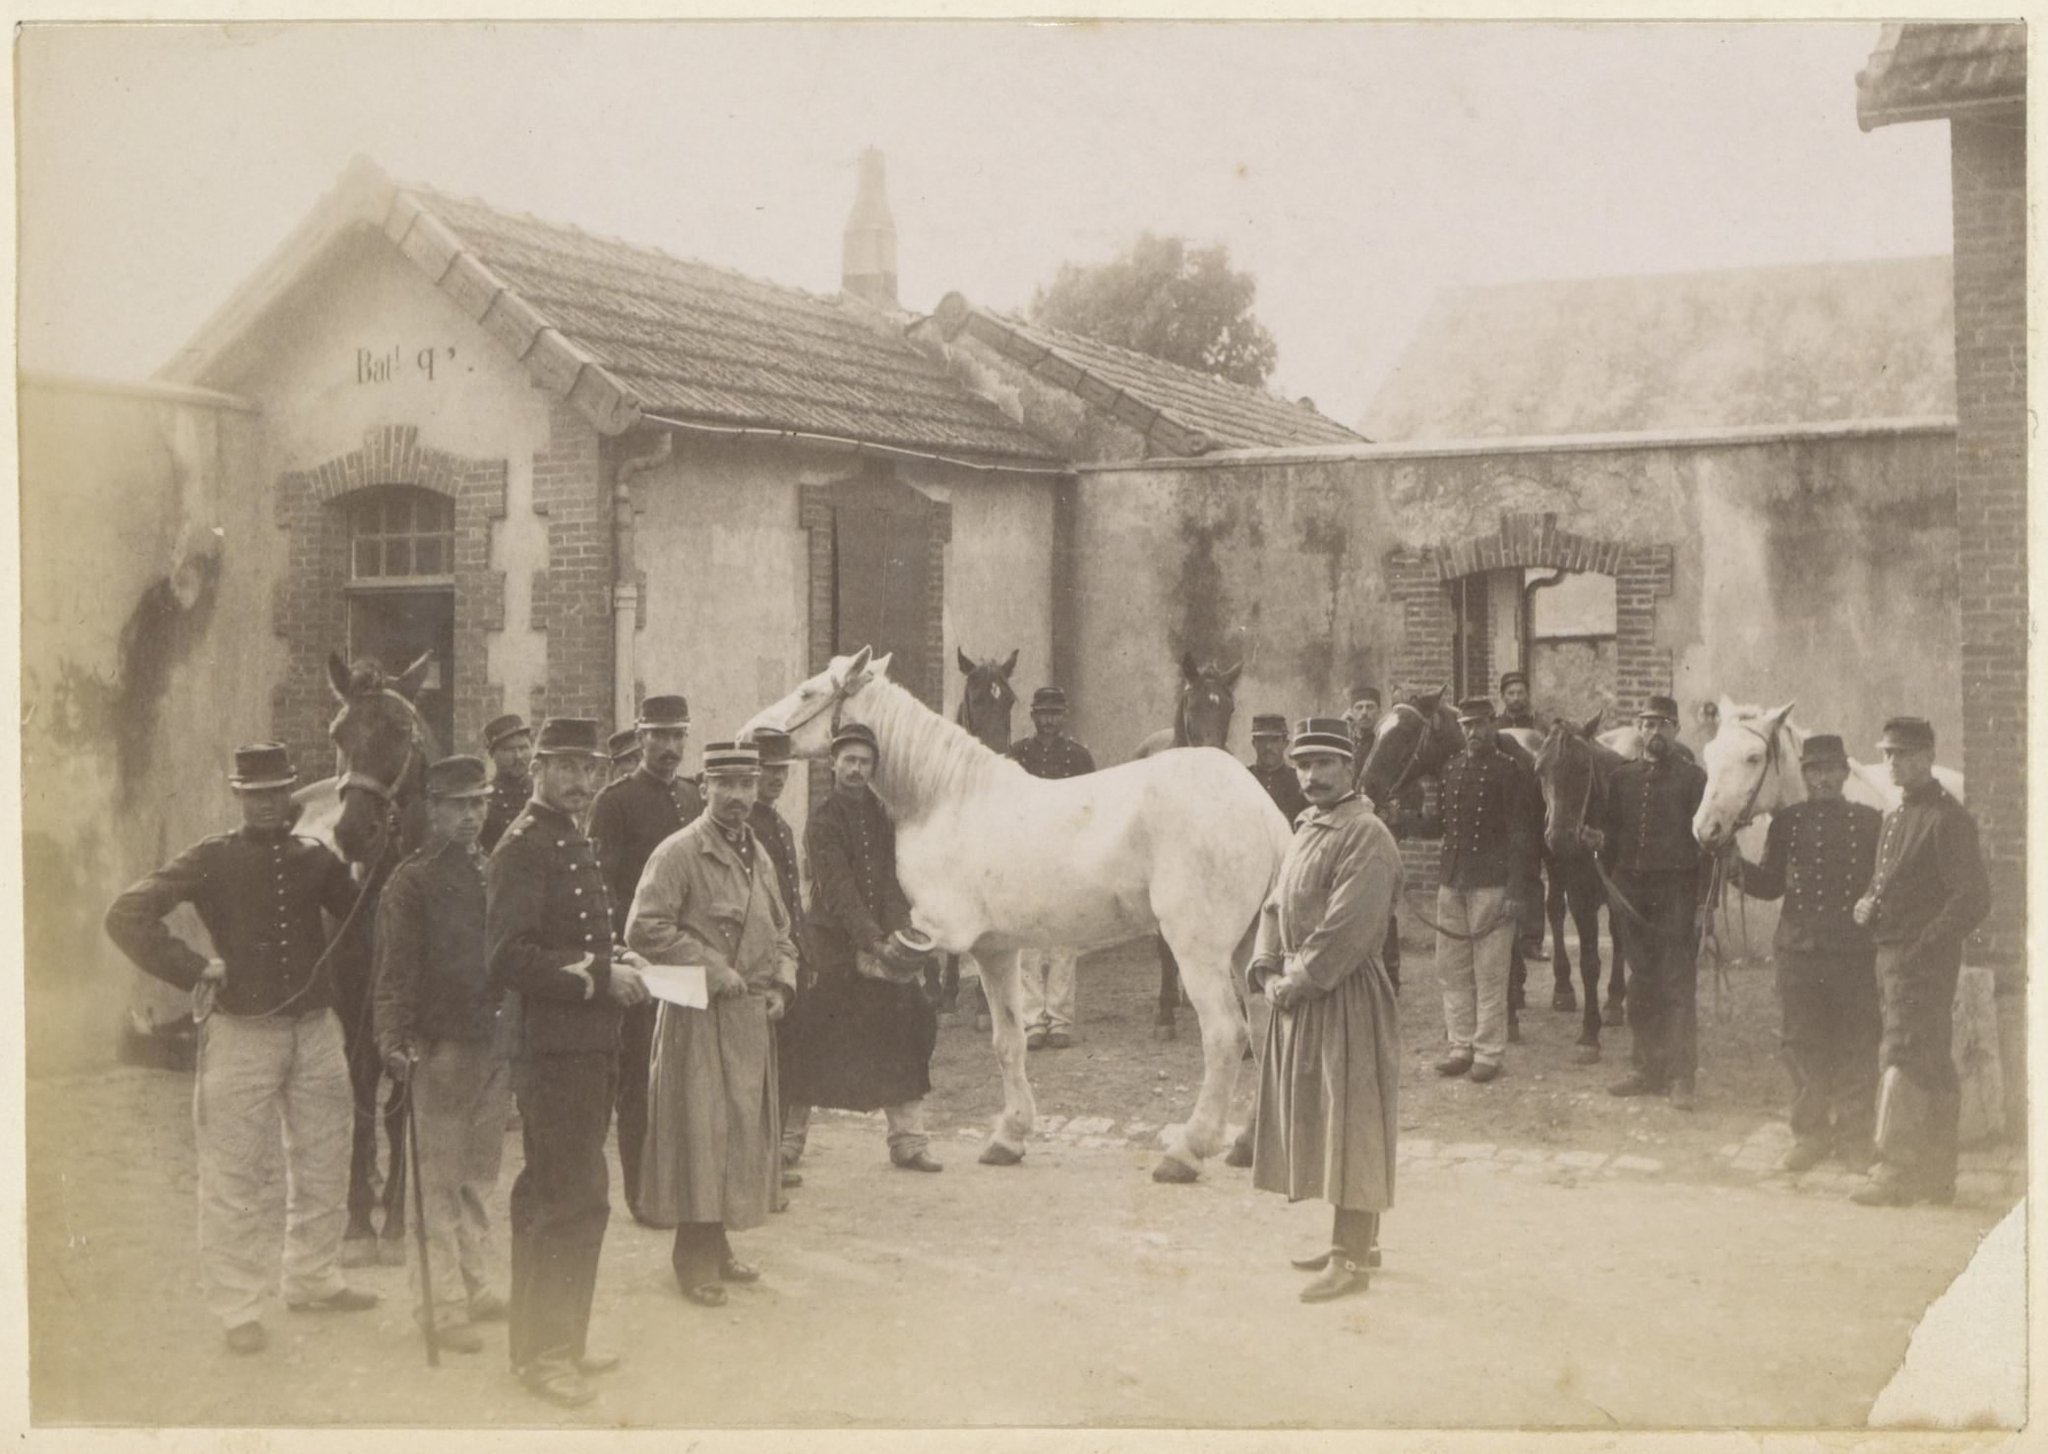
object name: photograph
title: Militairen met een paard bij een kazerne in Frankrijk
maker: Anonymous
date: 1900-1910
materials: paper, photographic support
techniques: albumen print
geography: france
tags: land forces, horse, (military) uniforms, france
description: Onderdeel van Fotoalbum van een Franse amateurfotograaf met opnames van een familie, distilleerderij Delizy & Doistau Fils, het leger en bezienswaardigheden in Frankrijk.